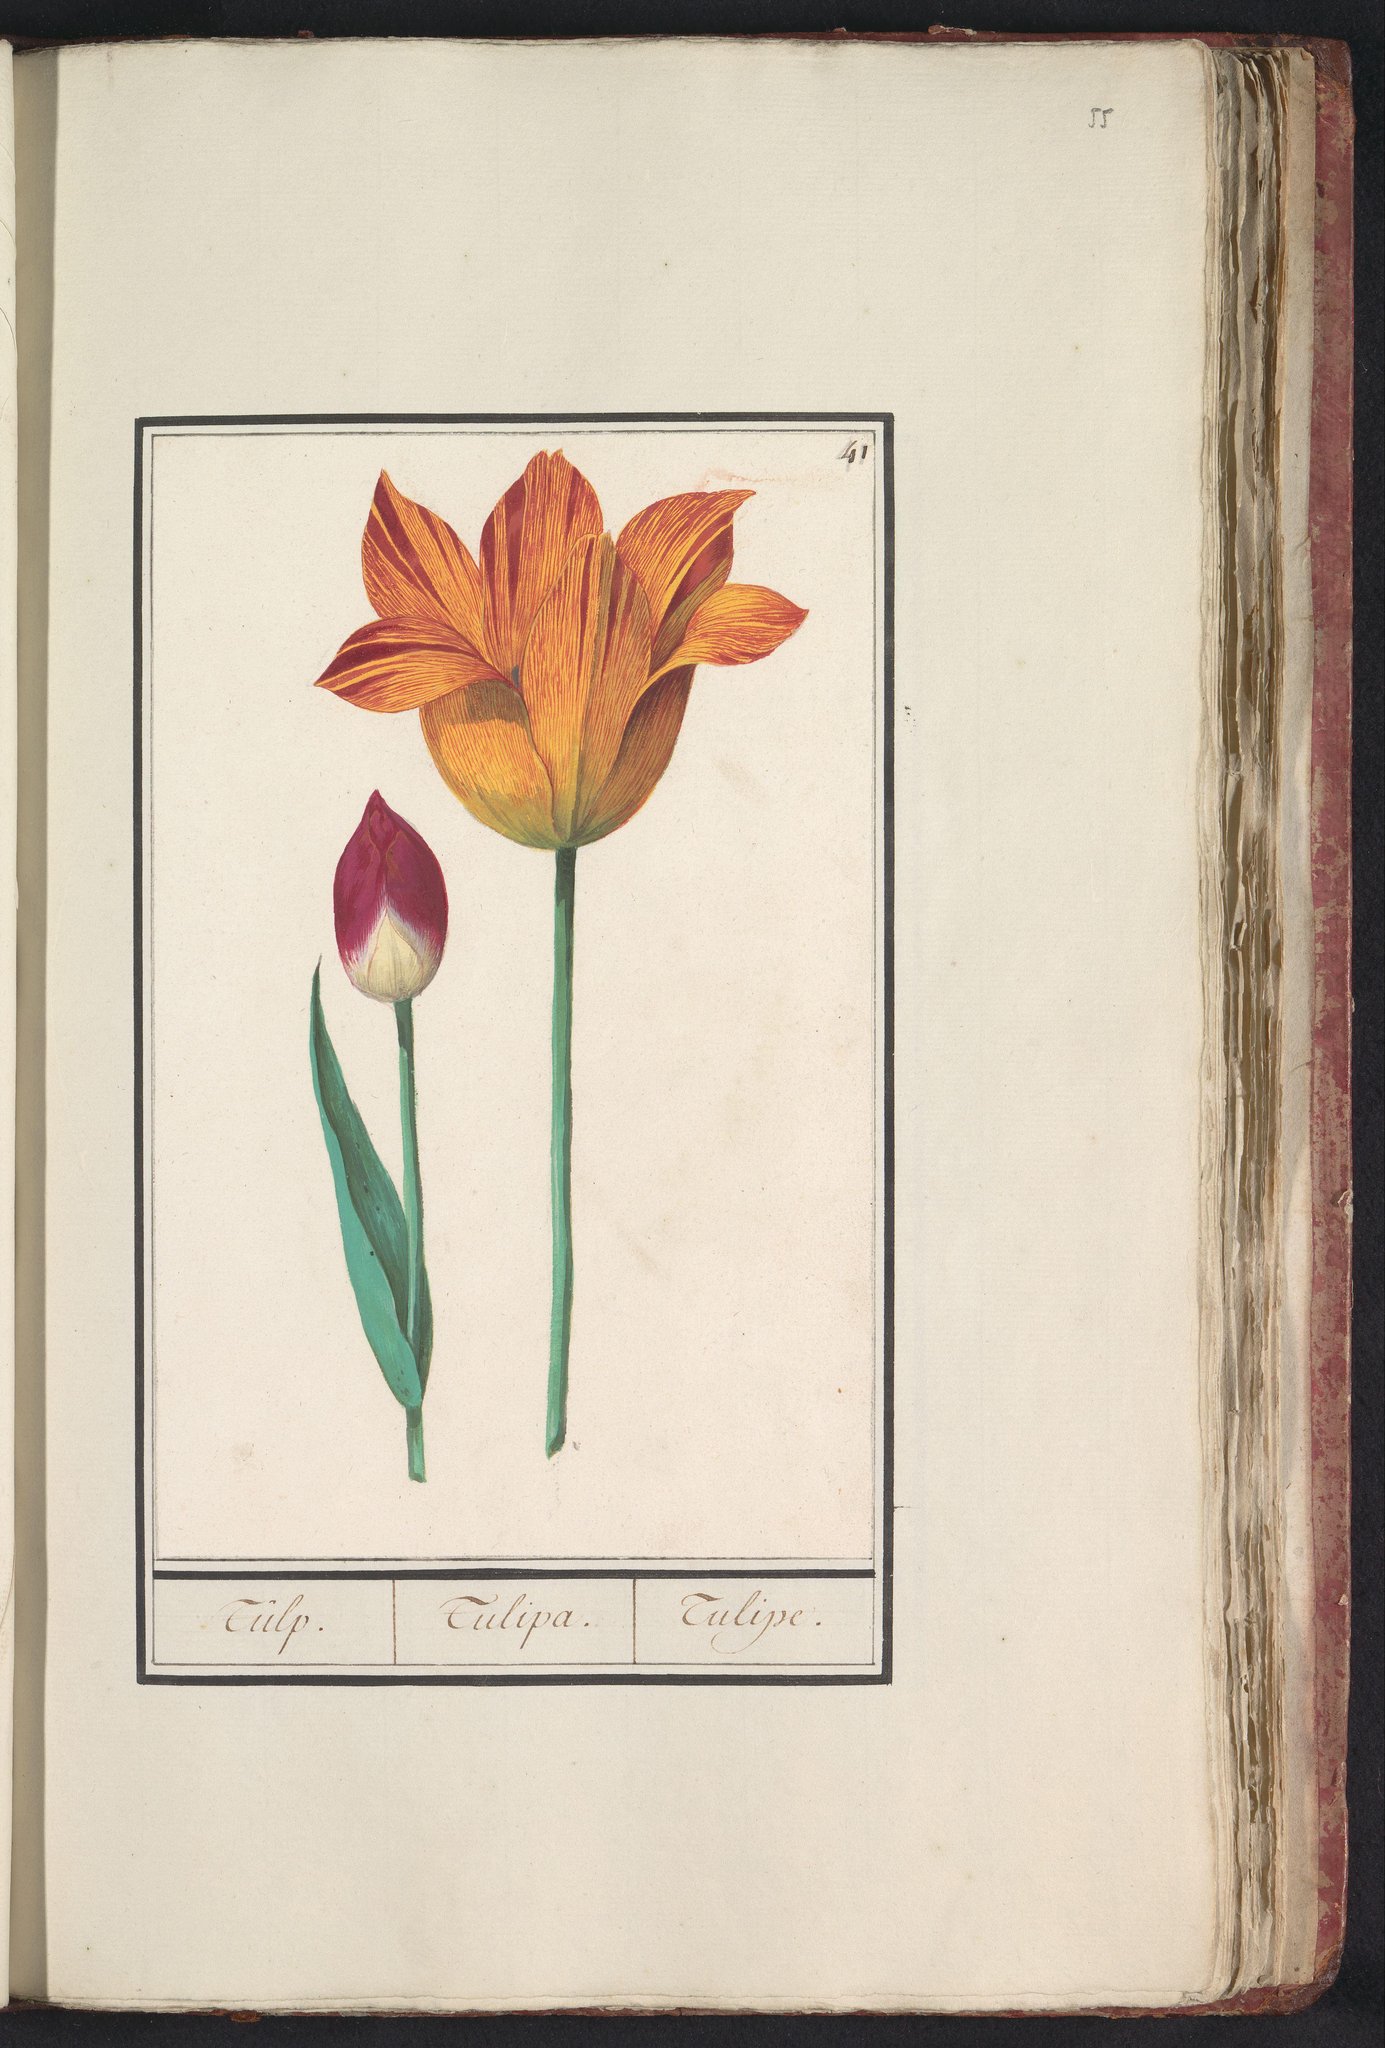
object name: drawing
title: Tulp. / Tulipa. / Tulipe.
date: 1596-1610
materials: chalk, paint, paper, watercolor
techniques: brush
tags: flowers: tulip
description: Rood-witte en oranje-rode tulp. Genummerd rechtsboven: 41. Onderdeel van het eerste album met tekeningen van bloemen en planten. Achtste van twaalf albums met tekeningen van dieren, vogels en planten bekend rond 1600, gemaakt in opdracht van keizer Rudolf II. Met toelichting in Nederlands, Latijn en Frans.